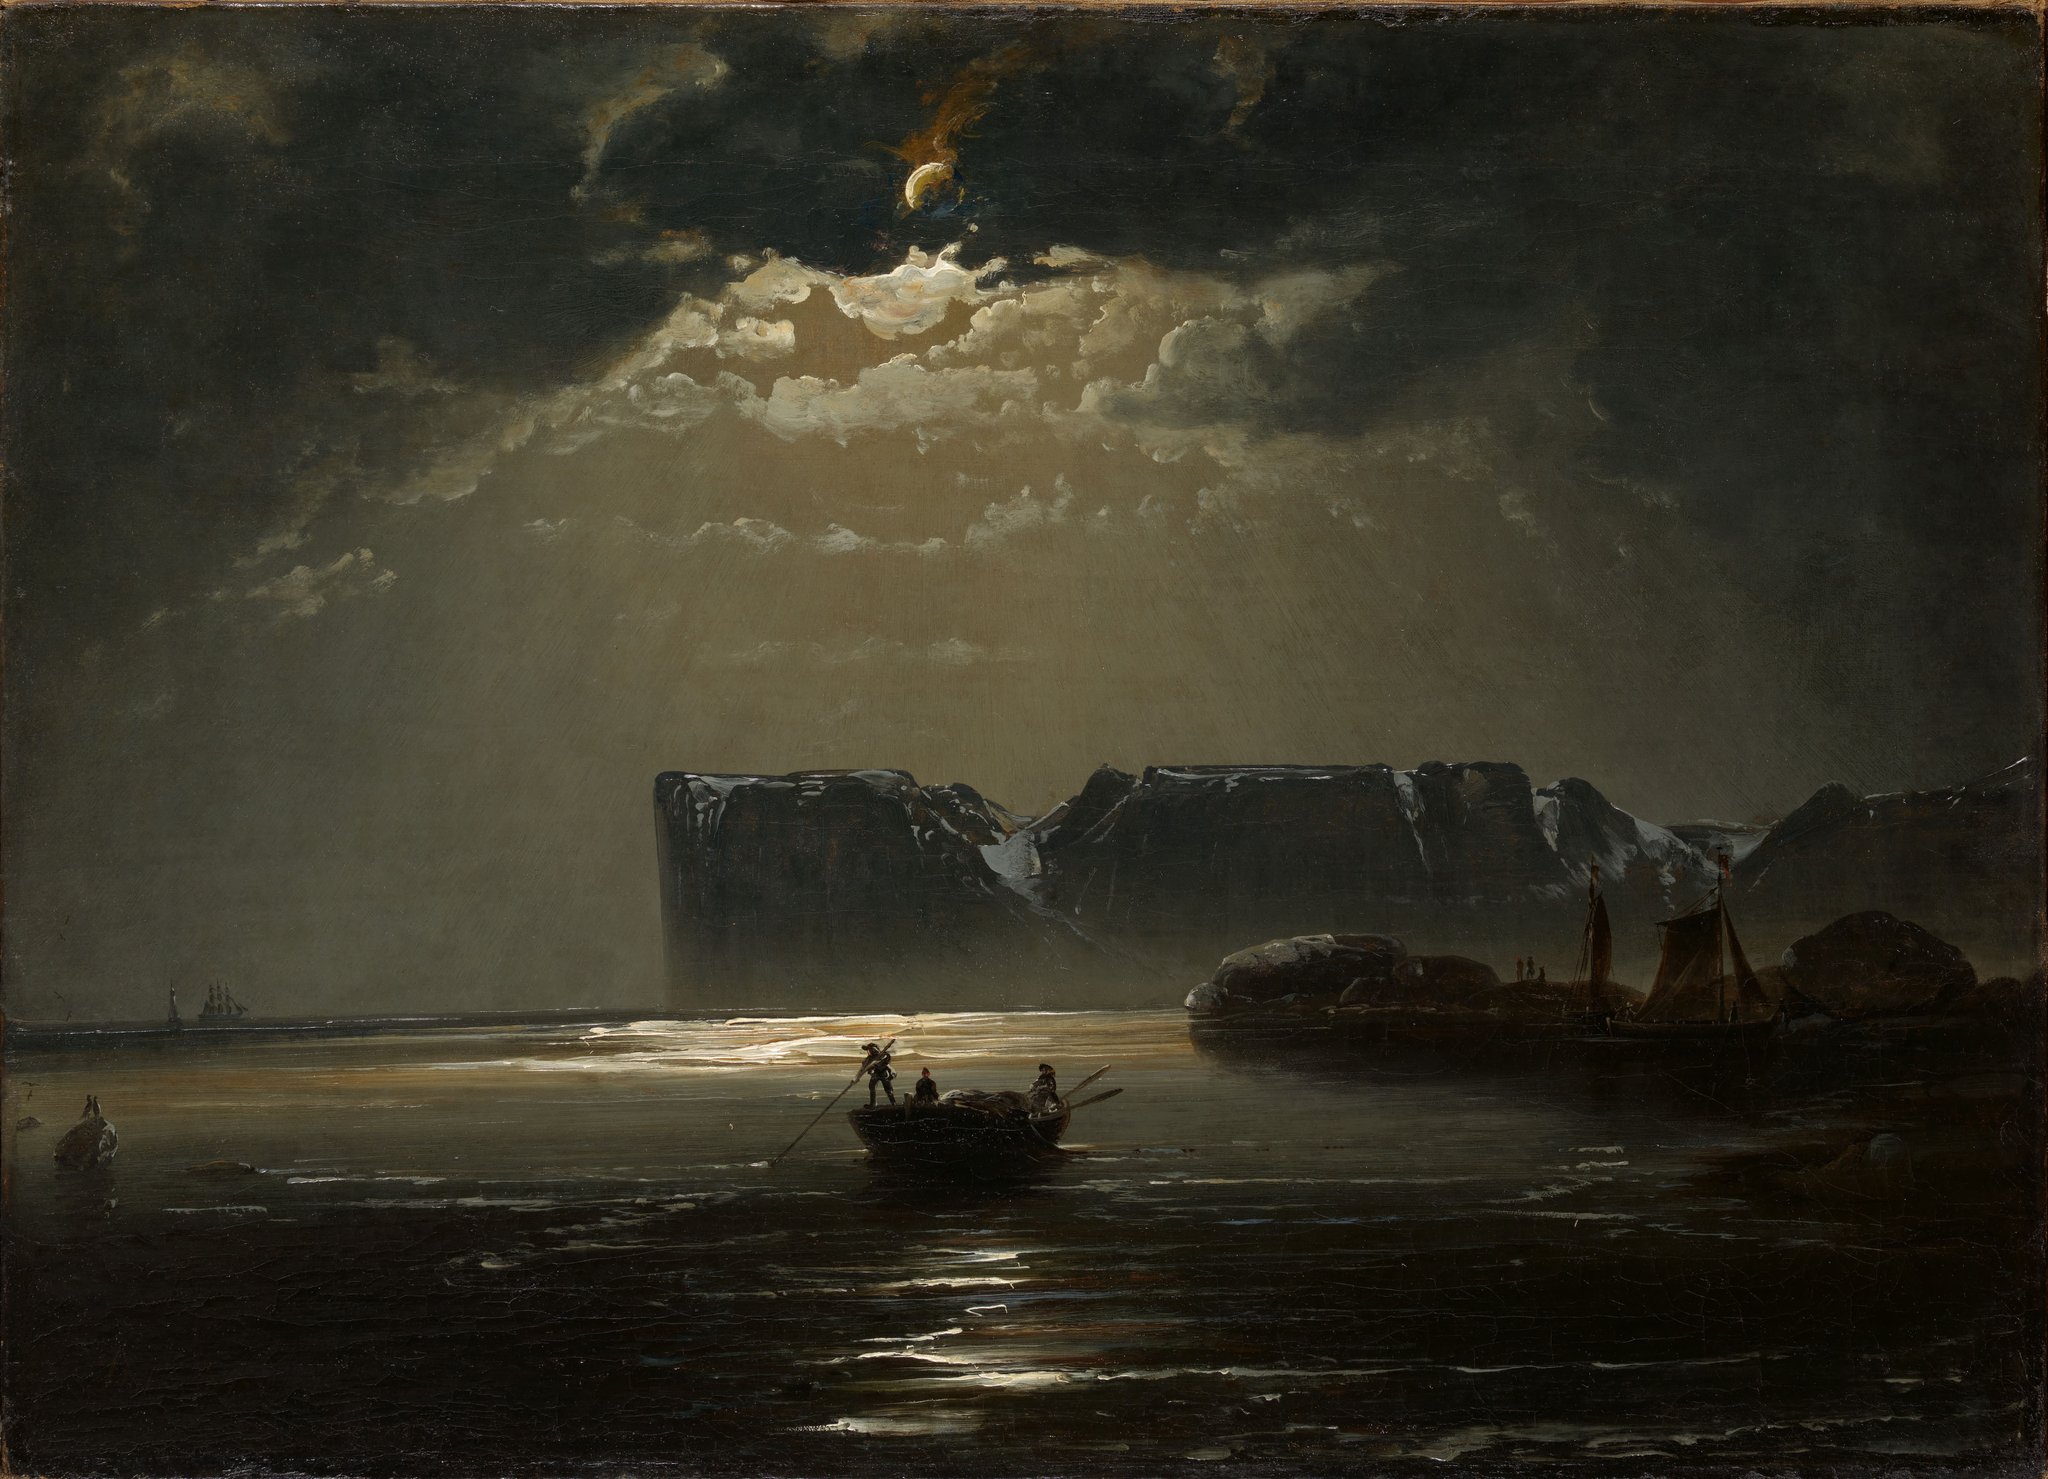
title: The North Cape by Moonlight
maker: peder balke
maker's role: artist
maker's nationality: norwegian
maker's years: 1804-1887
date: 1848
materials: canvas, oil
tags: seascapes,night,boats